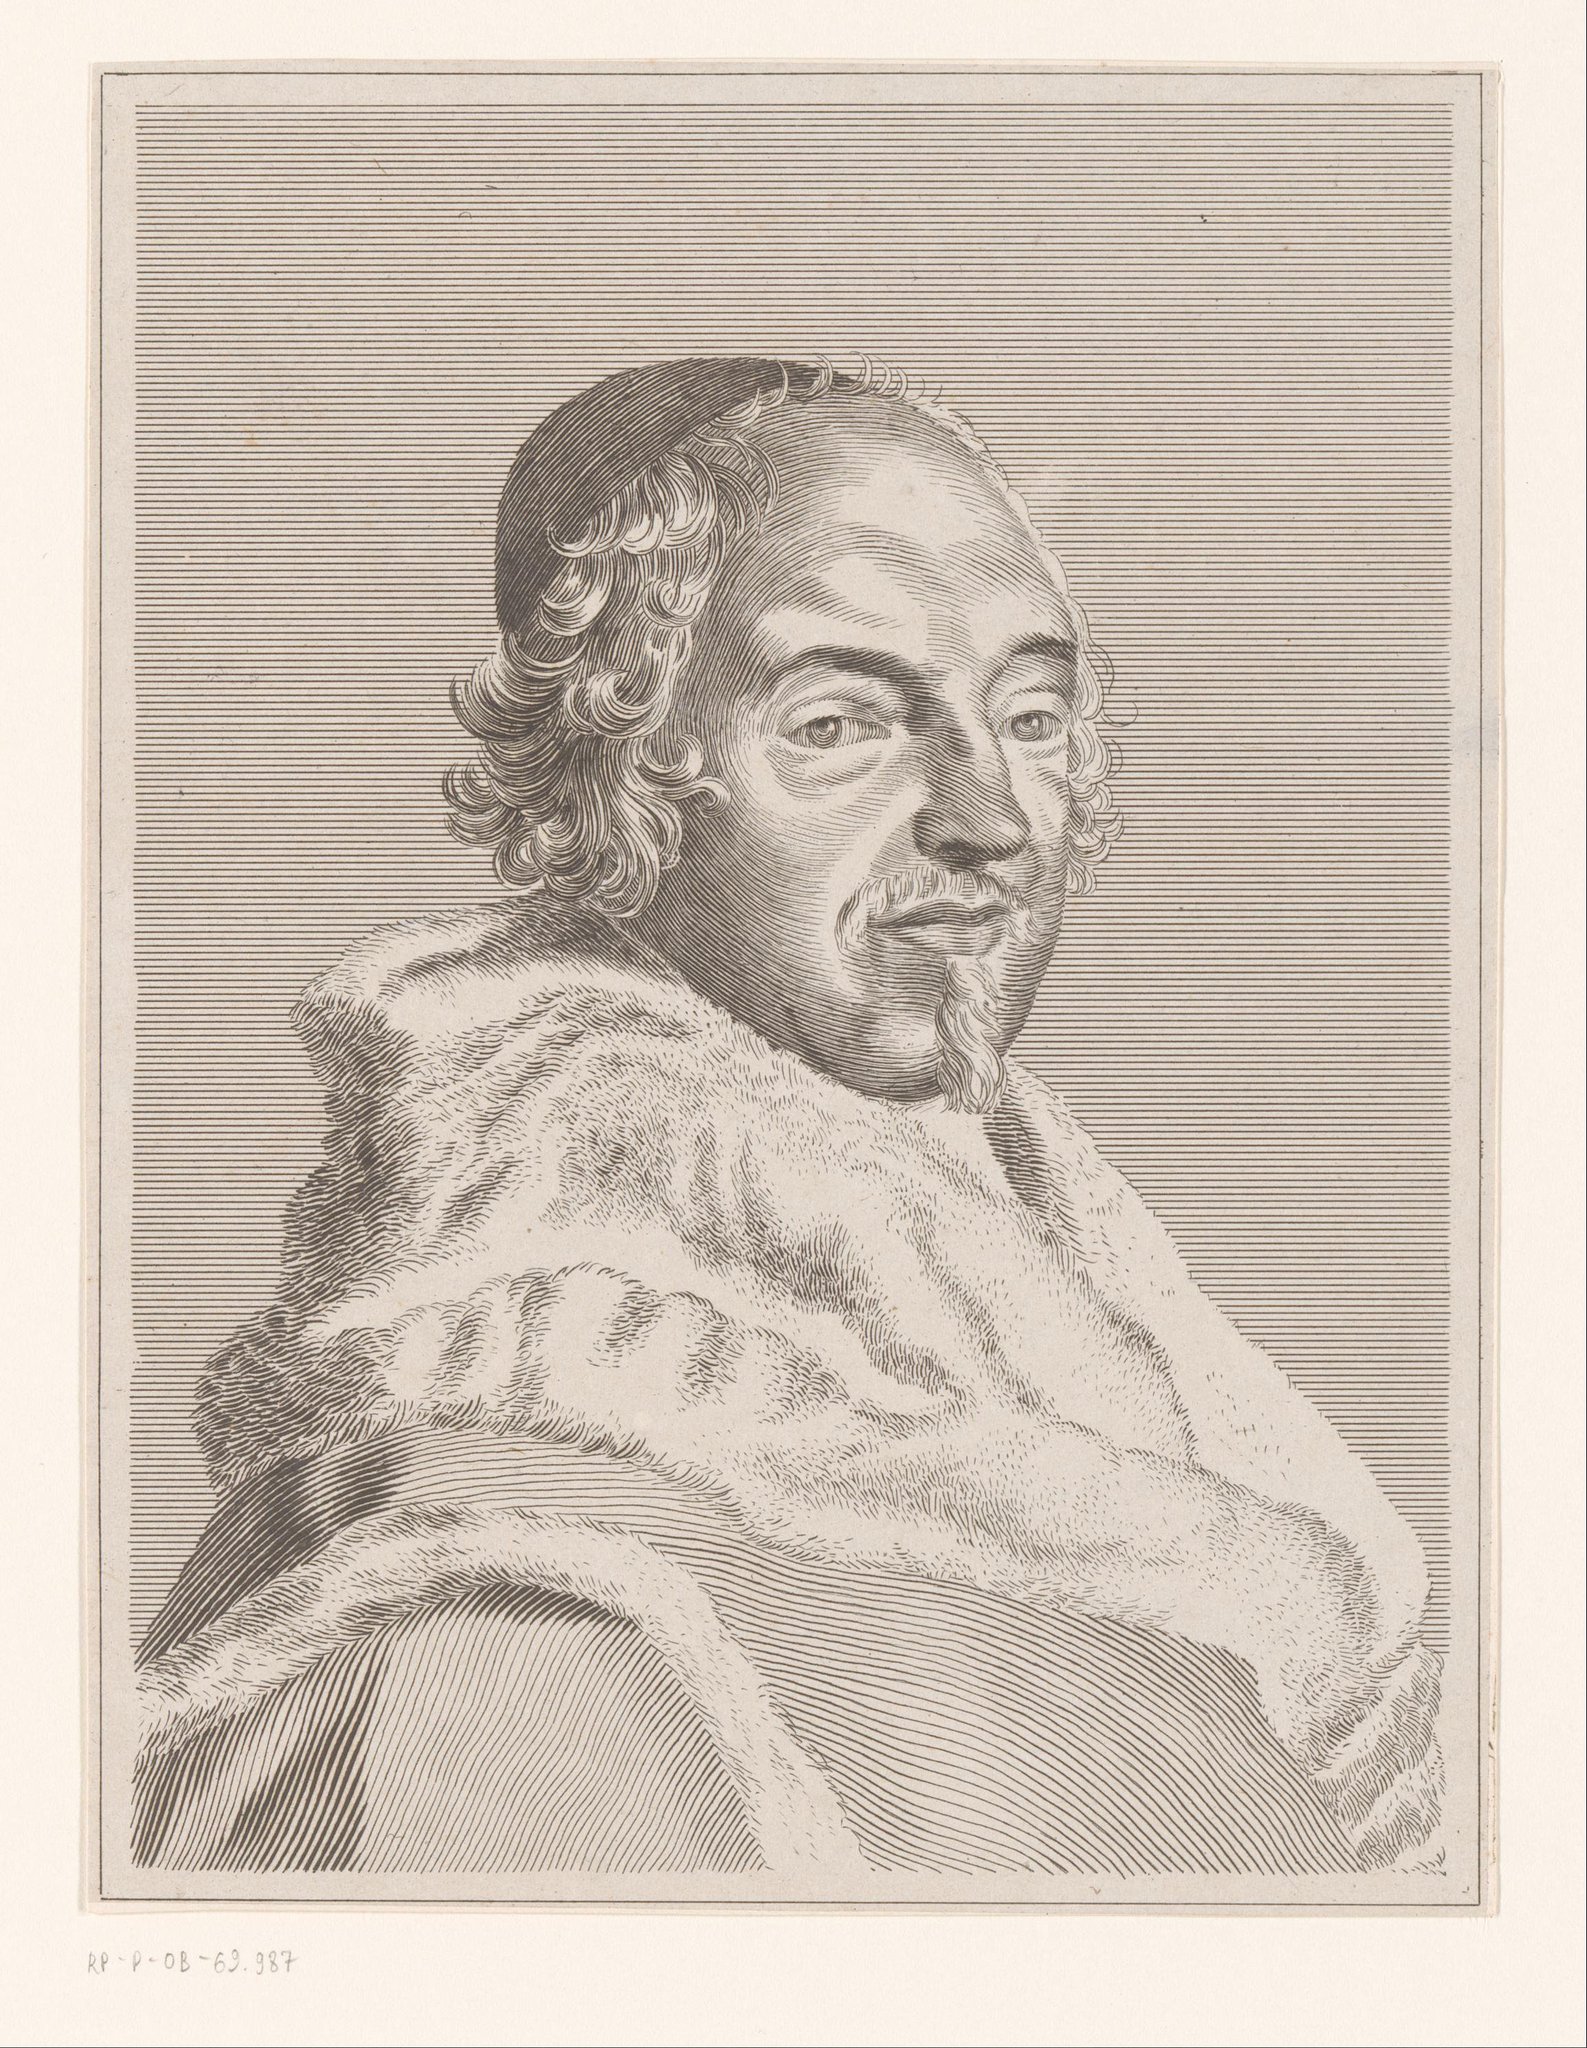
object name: print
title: Portret van François-Théodore de Nesmond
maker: Anonymous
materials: paper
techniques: engraving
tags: historical persons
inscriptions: collector's mark: Lugt 2228